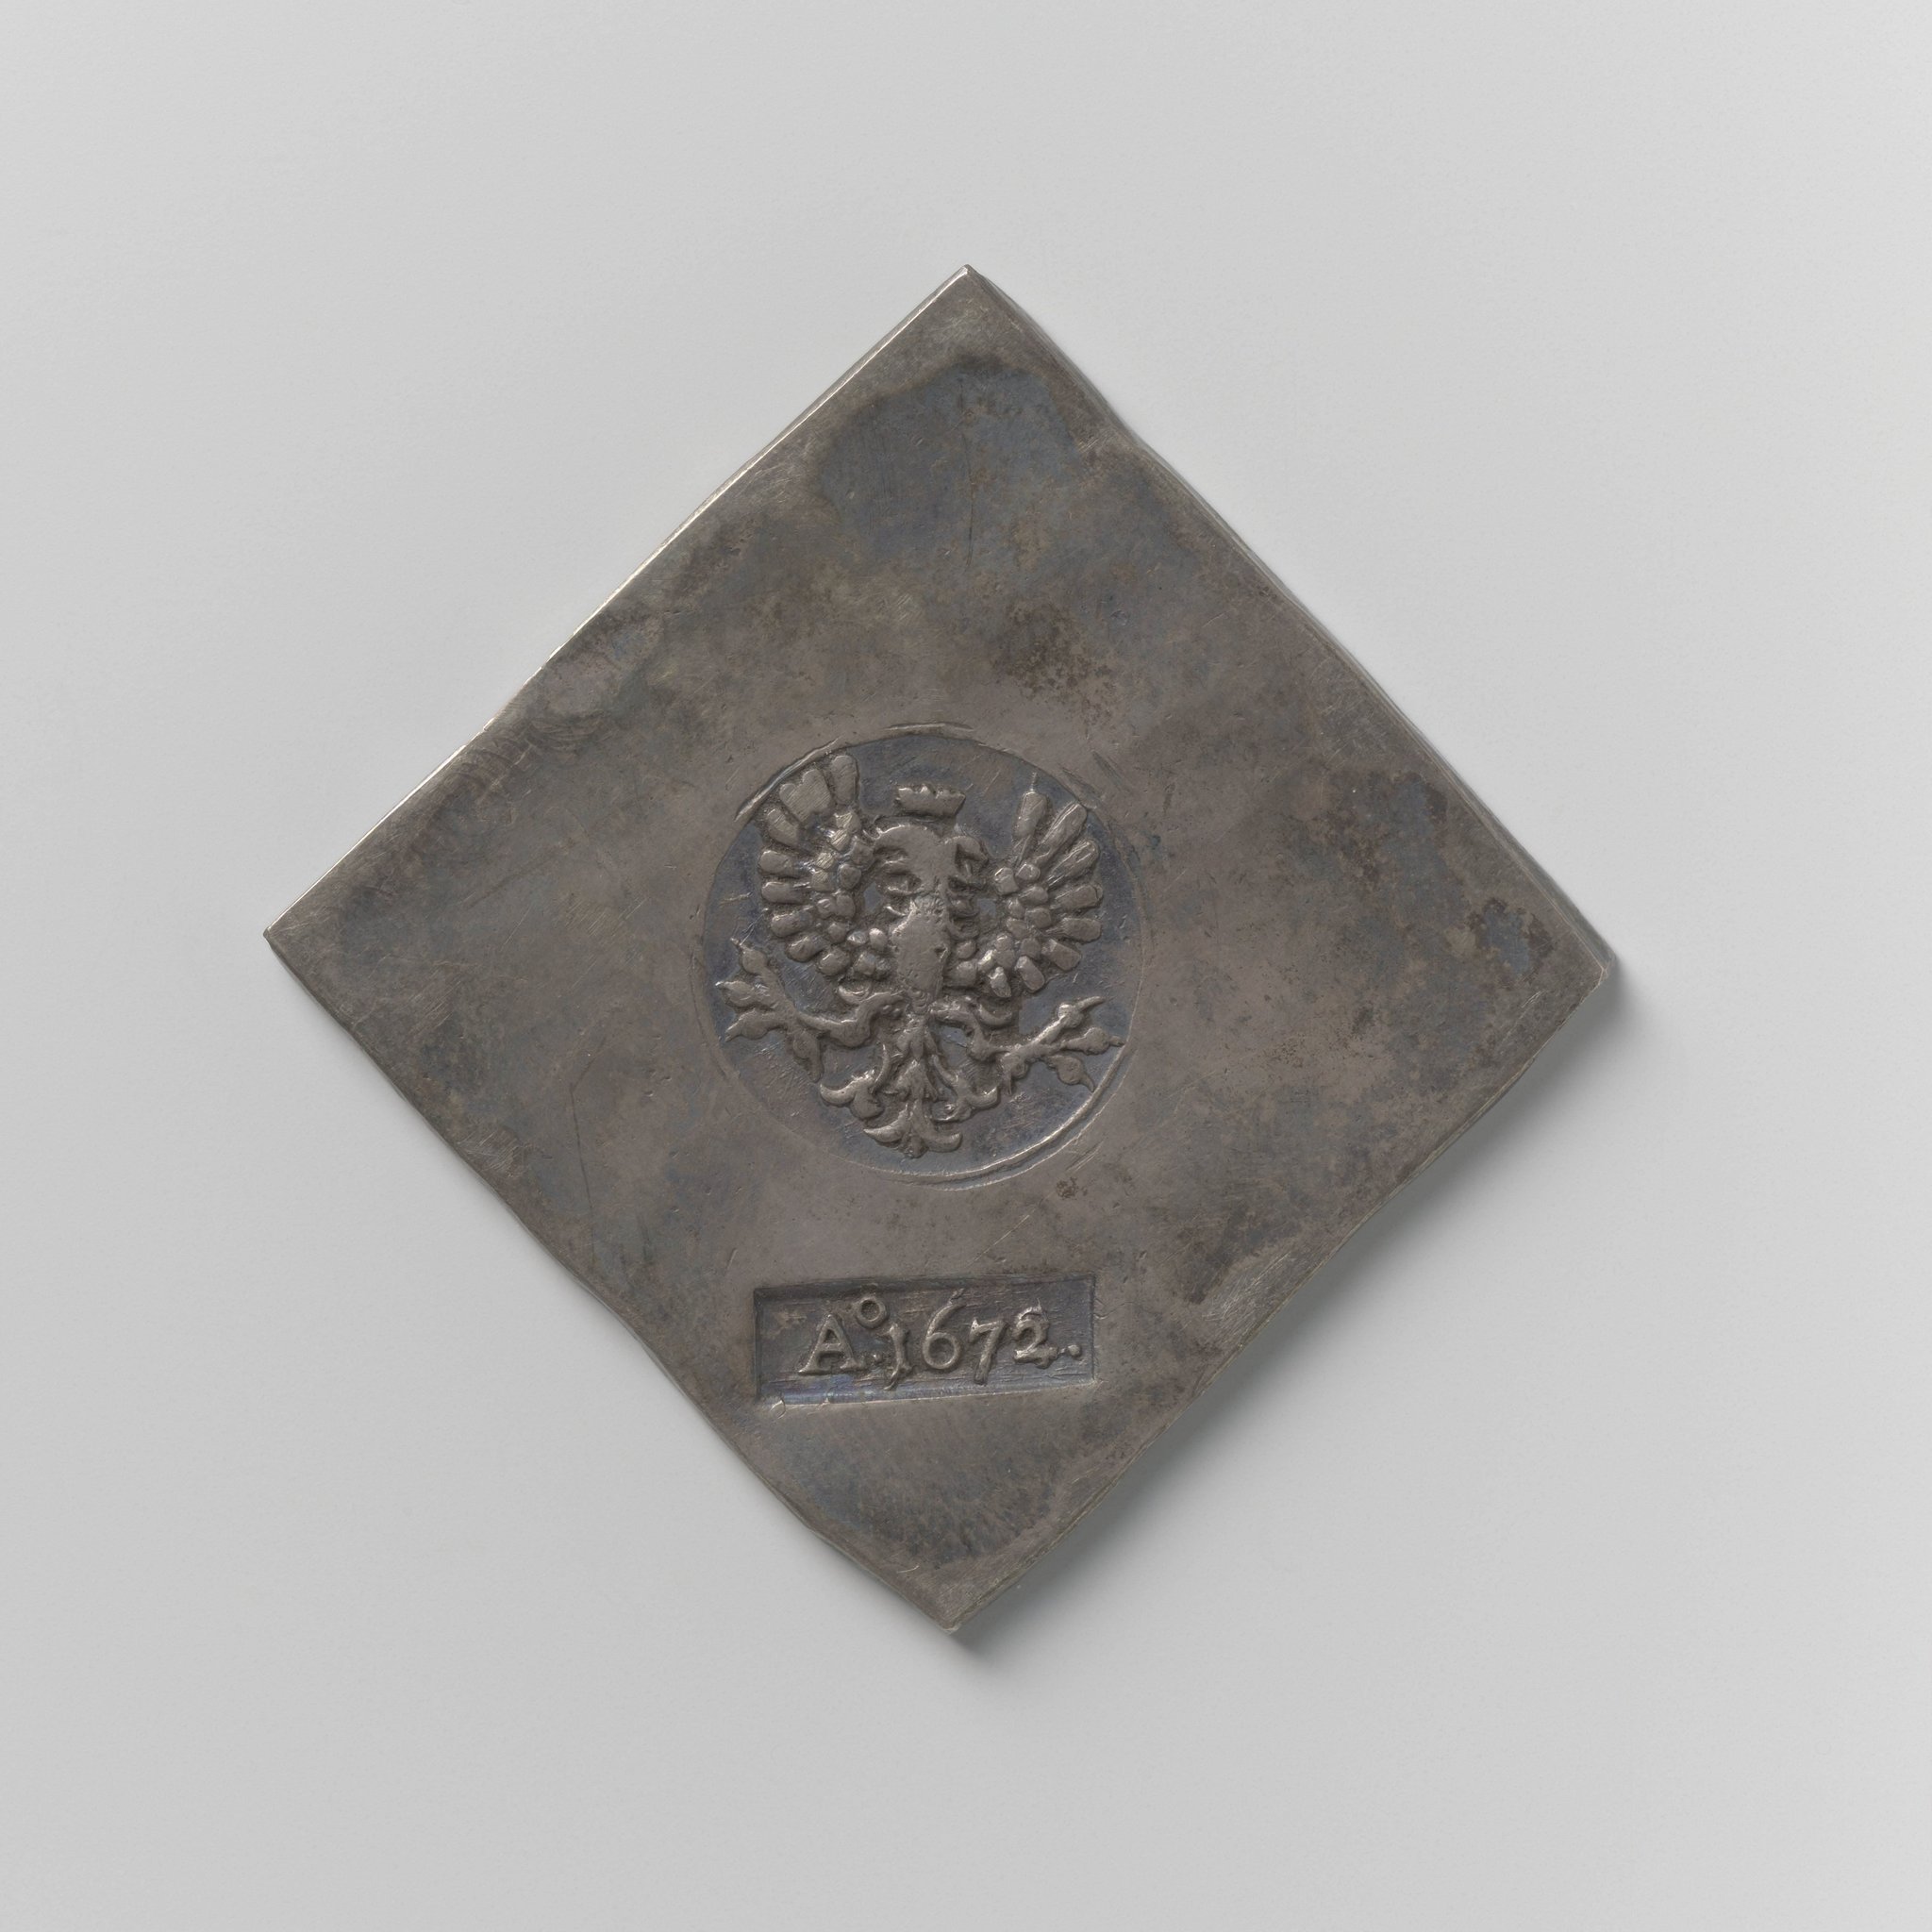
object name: thaler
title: daalder, noodmunt uit Deventer, vervaardigd tijdens het beleg uit het raadszilver ter betaling van de oorlogskosten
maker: lucas lucassen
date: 1672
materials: silver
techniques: engraving, striking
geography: kampen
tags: deventer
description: ruitvormige noodmunt. Voorzijde: twee stempels: grote, ronde stempel: gekroonde adelaar; daaronder: rechthoekige stempel met jaartal. Keerzijde: gegraveerd opschrift: "Door vyands maght en paaps geweldt verkeert ons glans in vierkandt geldt H. N."